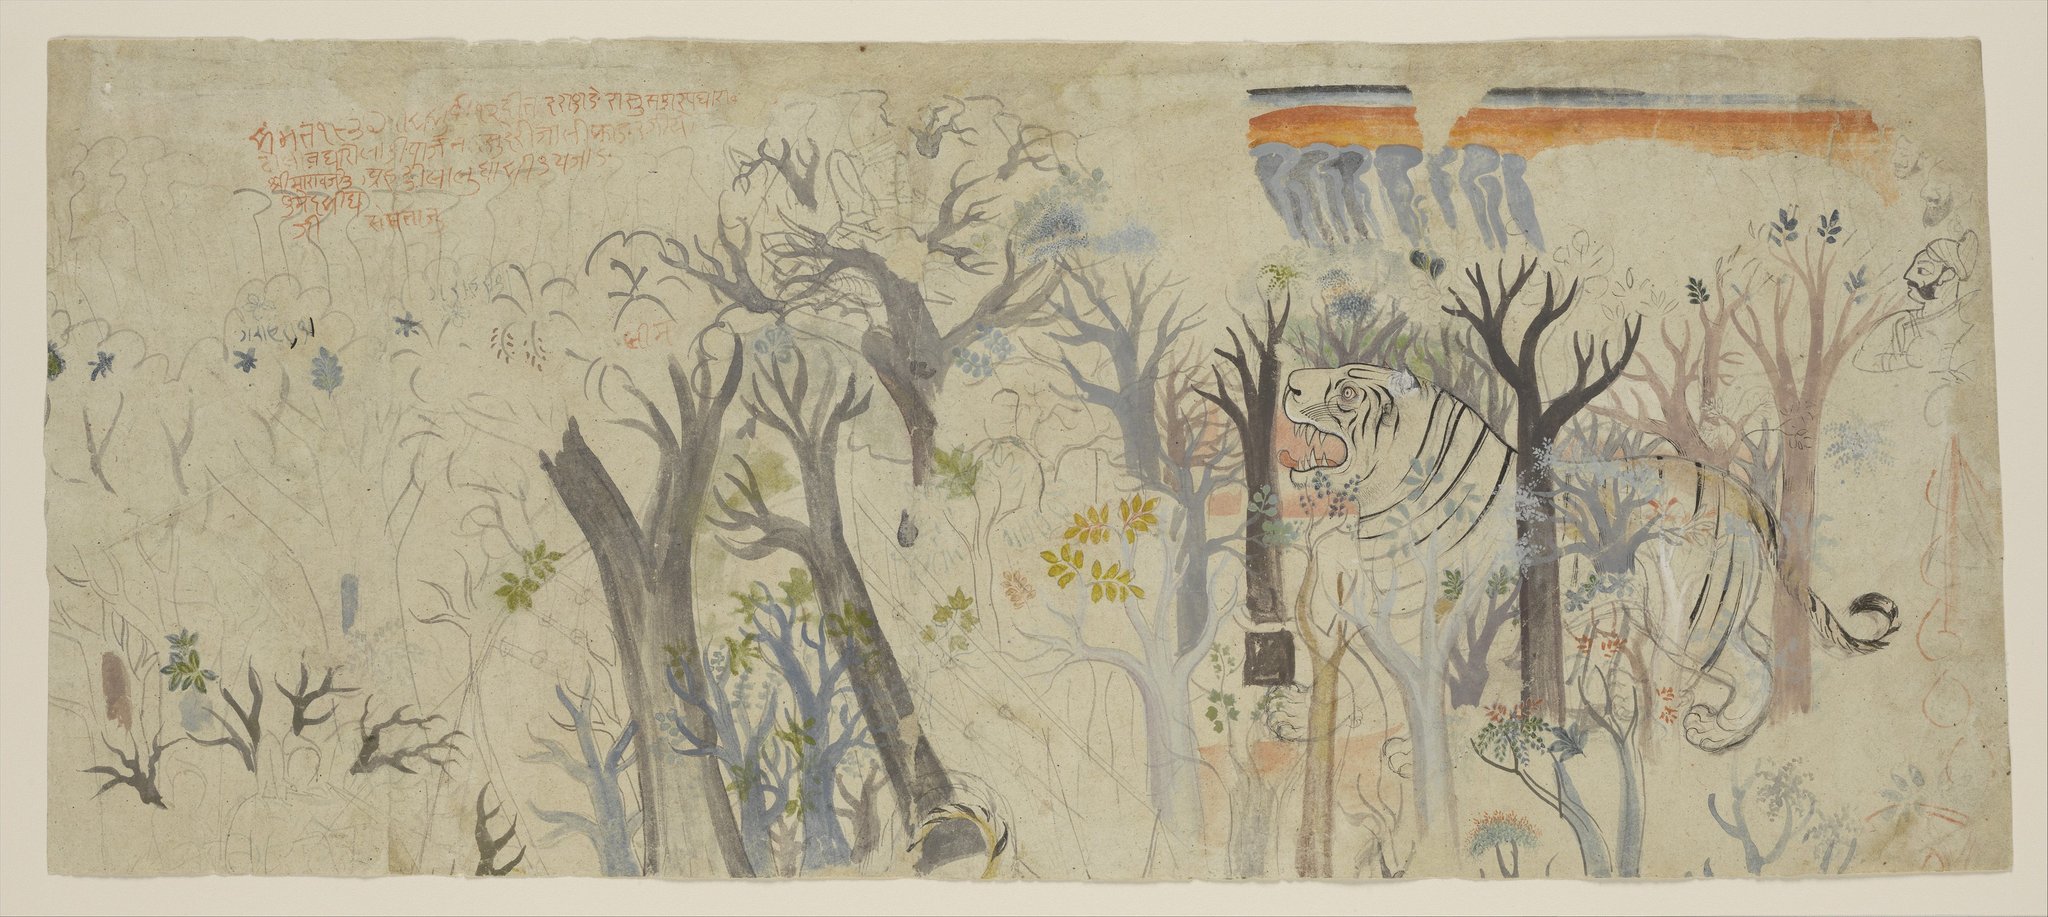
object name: painting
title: Study for a Tiger Hunt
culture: indian, rajasthani, kota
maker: sheikh taju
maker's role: artist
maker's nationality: indian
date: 1780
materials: ink, paper, watercolor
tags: tigers